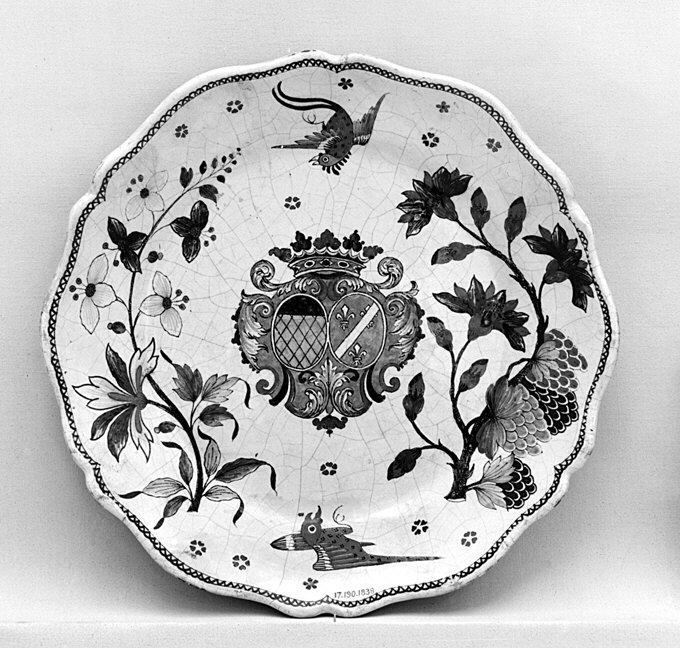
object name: plate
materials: faience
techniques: glazing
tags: birds,flowers,coat of arms